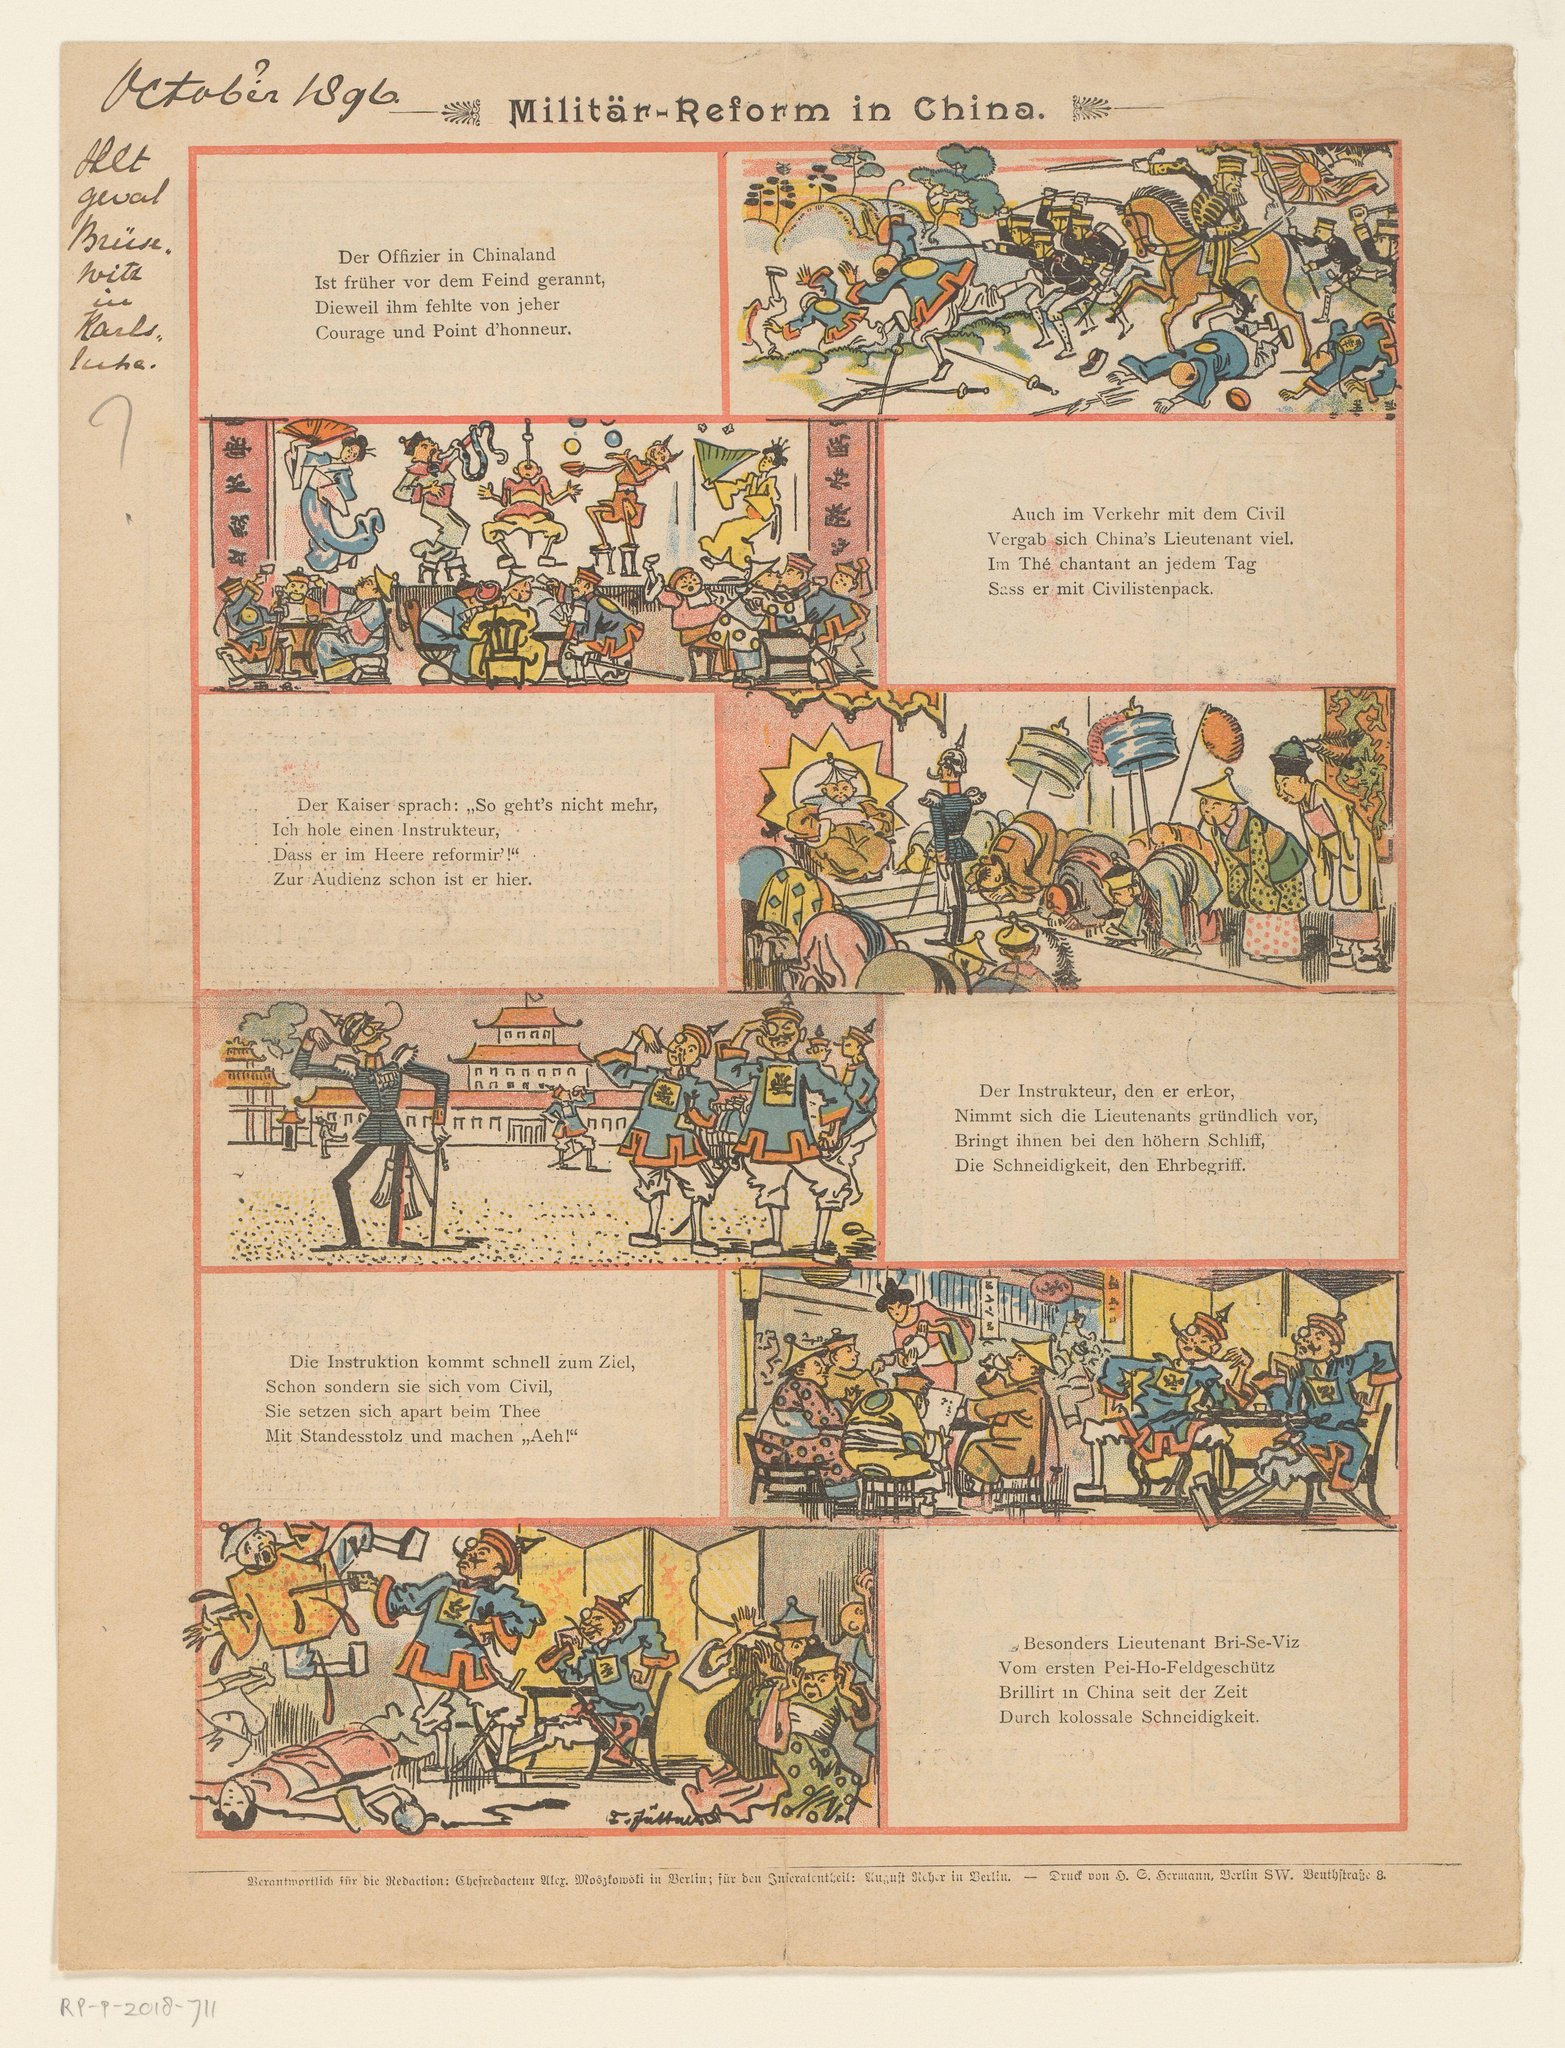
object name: print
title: Duitse militaire hervormingen in China, ca. 1900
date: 1890-1910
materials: paper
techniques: printed materials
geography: germany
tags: wilhelm ii (keizer van duitsland), military training, china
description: Strip over Duitse militaire hervormingen door keizer Wilhelm I in China, ca. 1900. In zes scènes met verzen. Blad genomen uit een onbekend Duits tijdschrift.